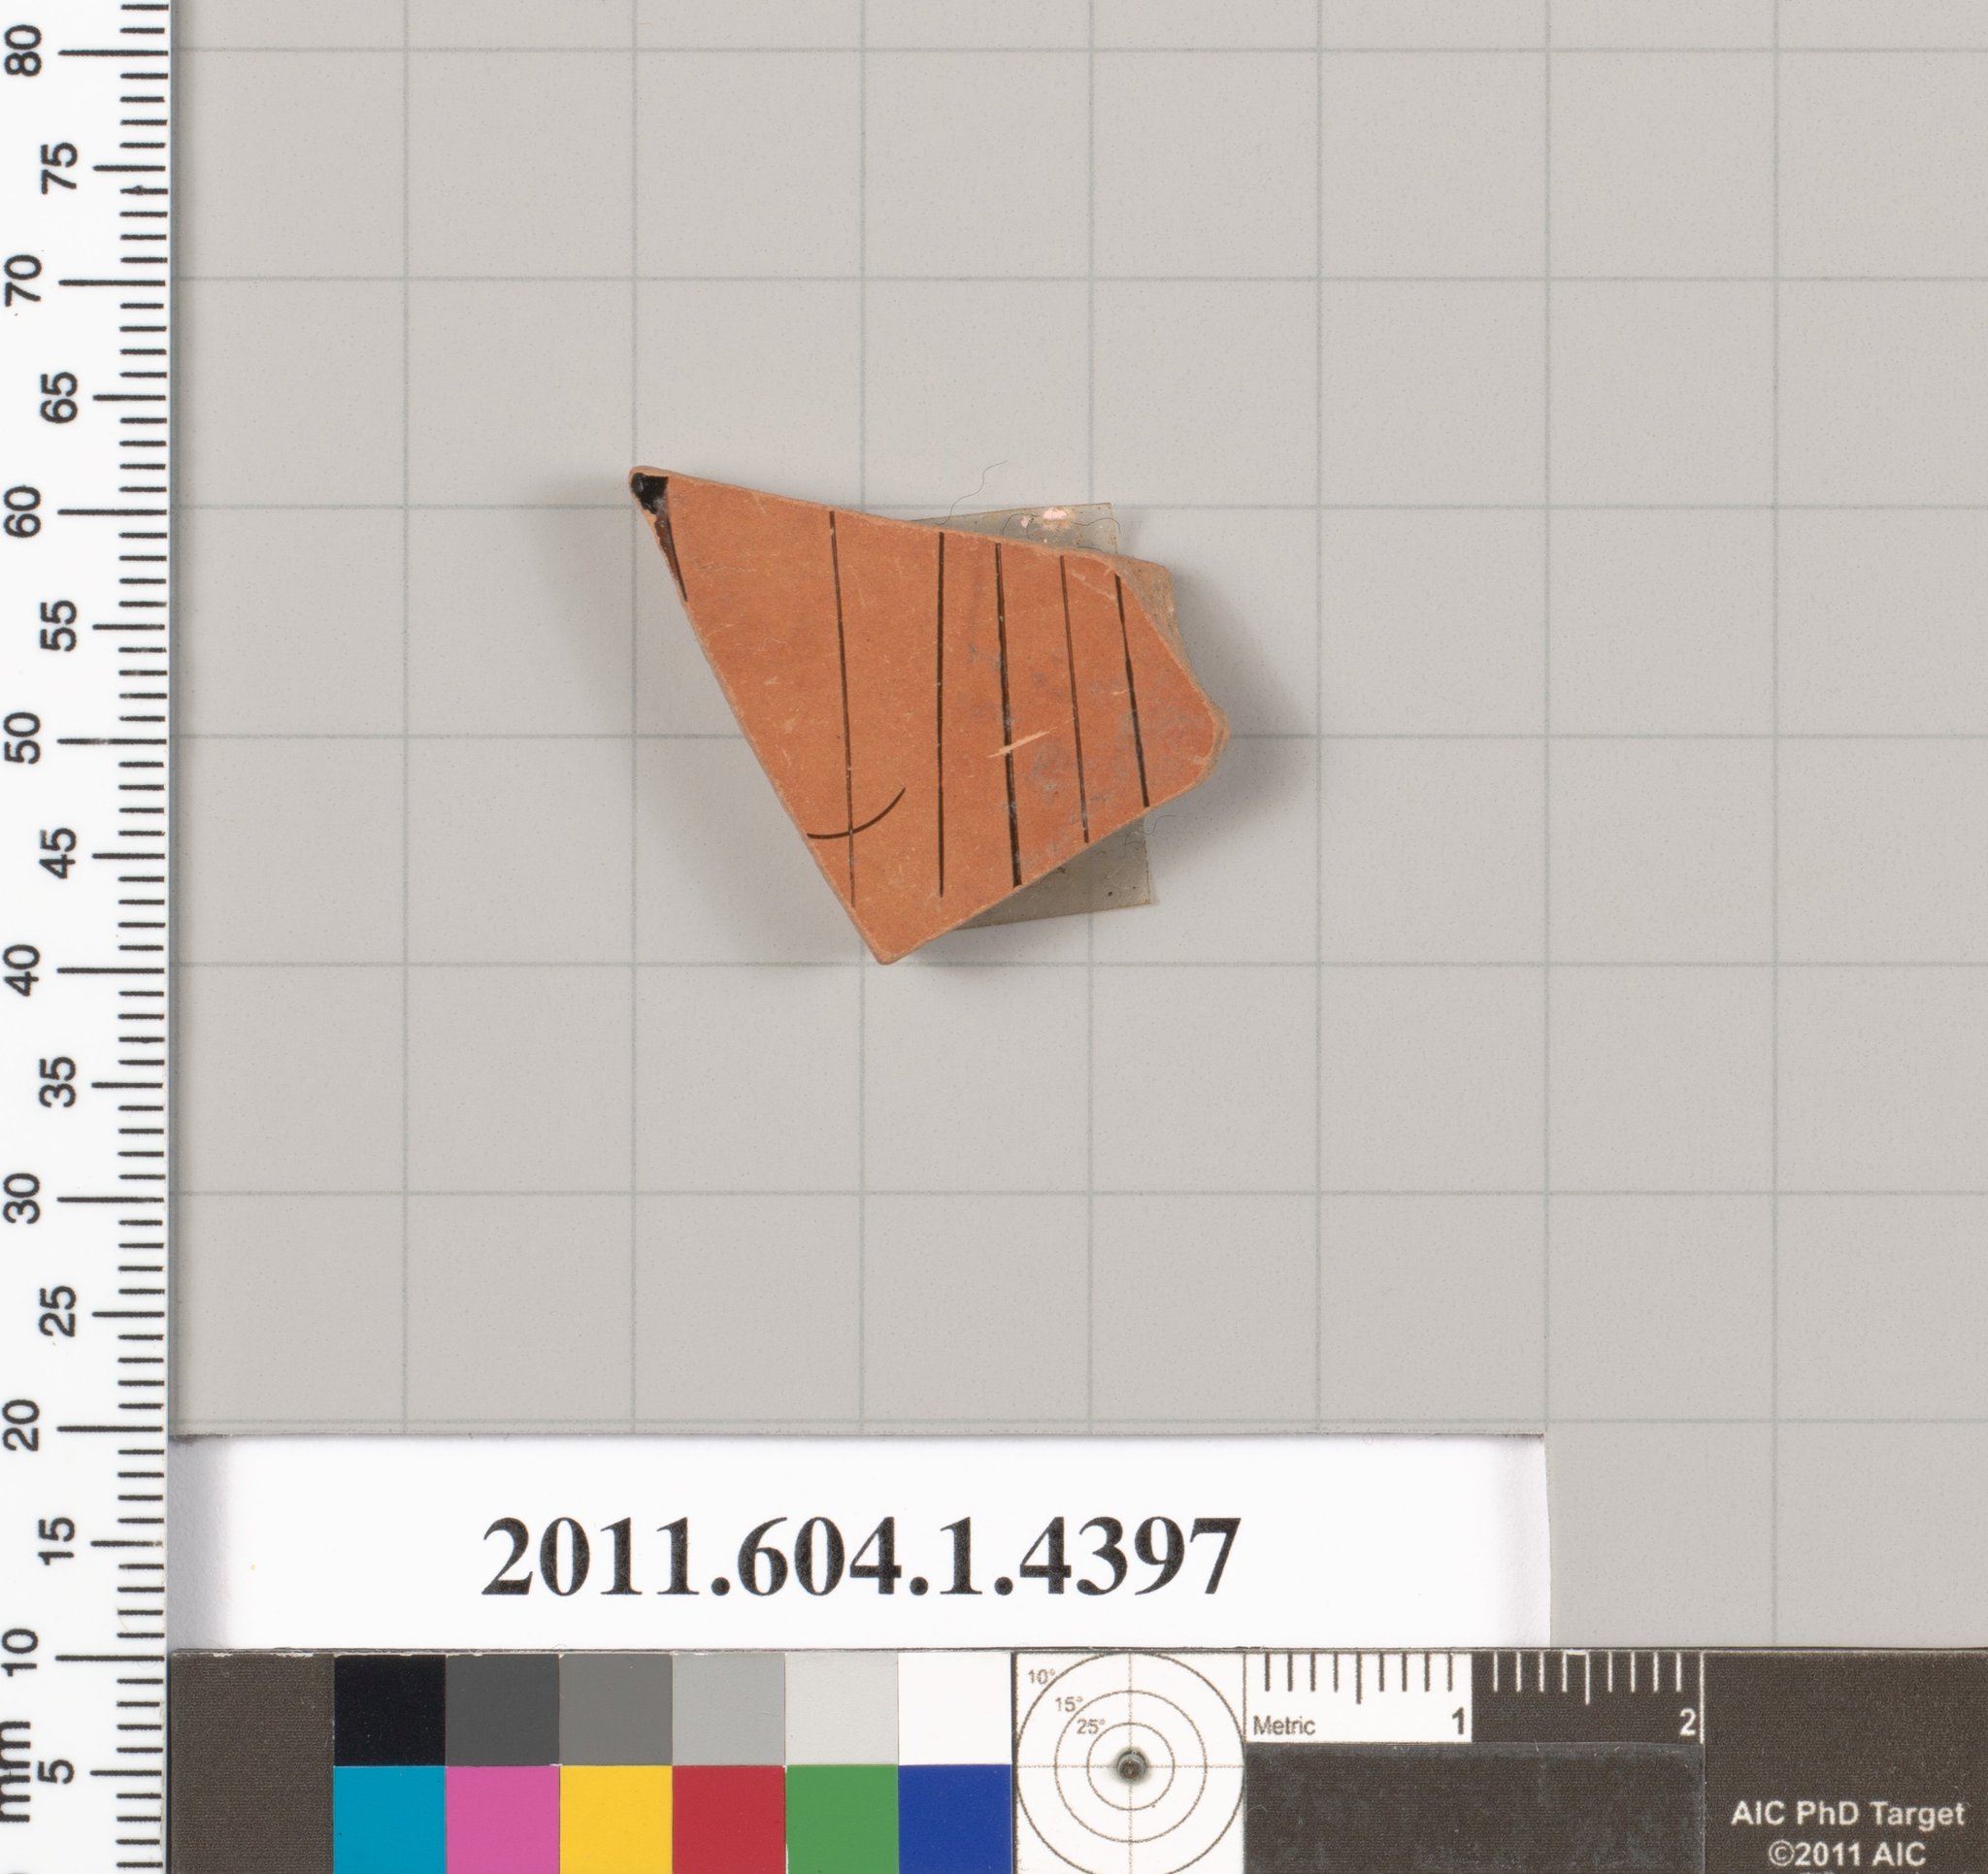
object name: kylix fragment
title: Terracotta fragment of a kylix (drinking cup)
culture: greek, attic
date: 475-451 BCE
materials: terracotta